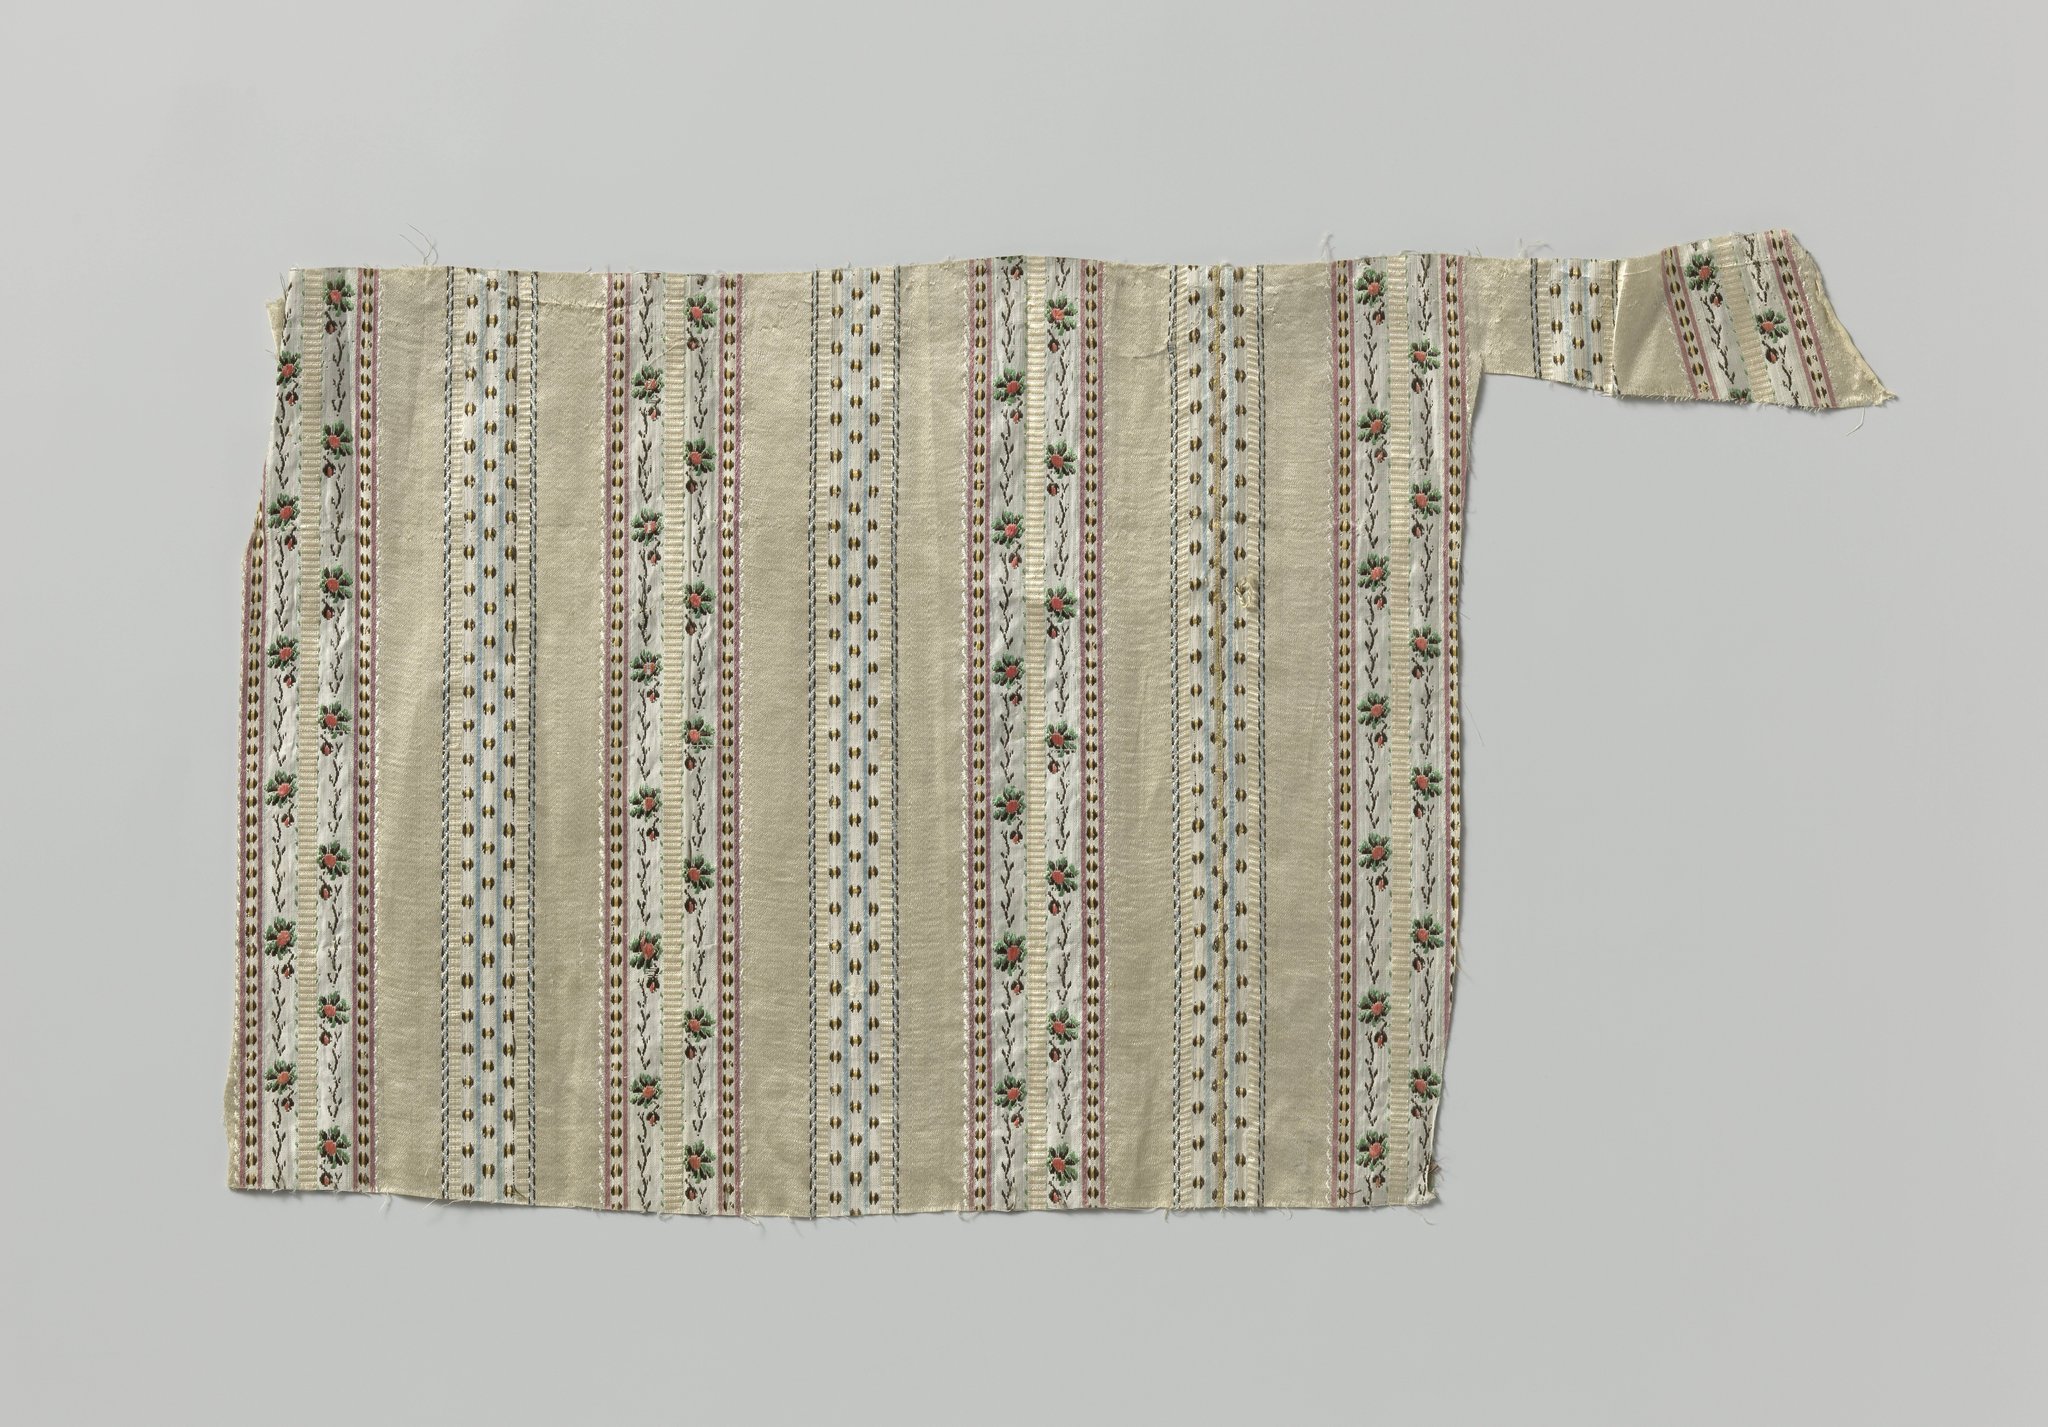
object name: silk textile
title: Fragment gestreept zijdeweefsel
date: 1750-1800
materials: silk